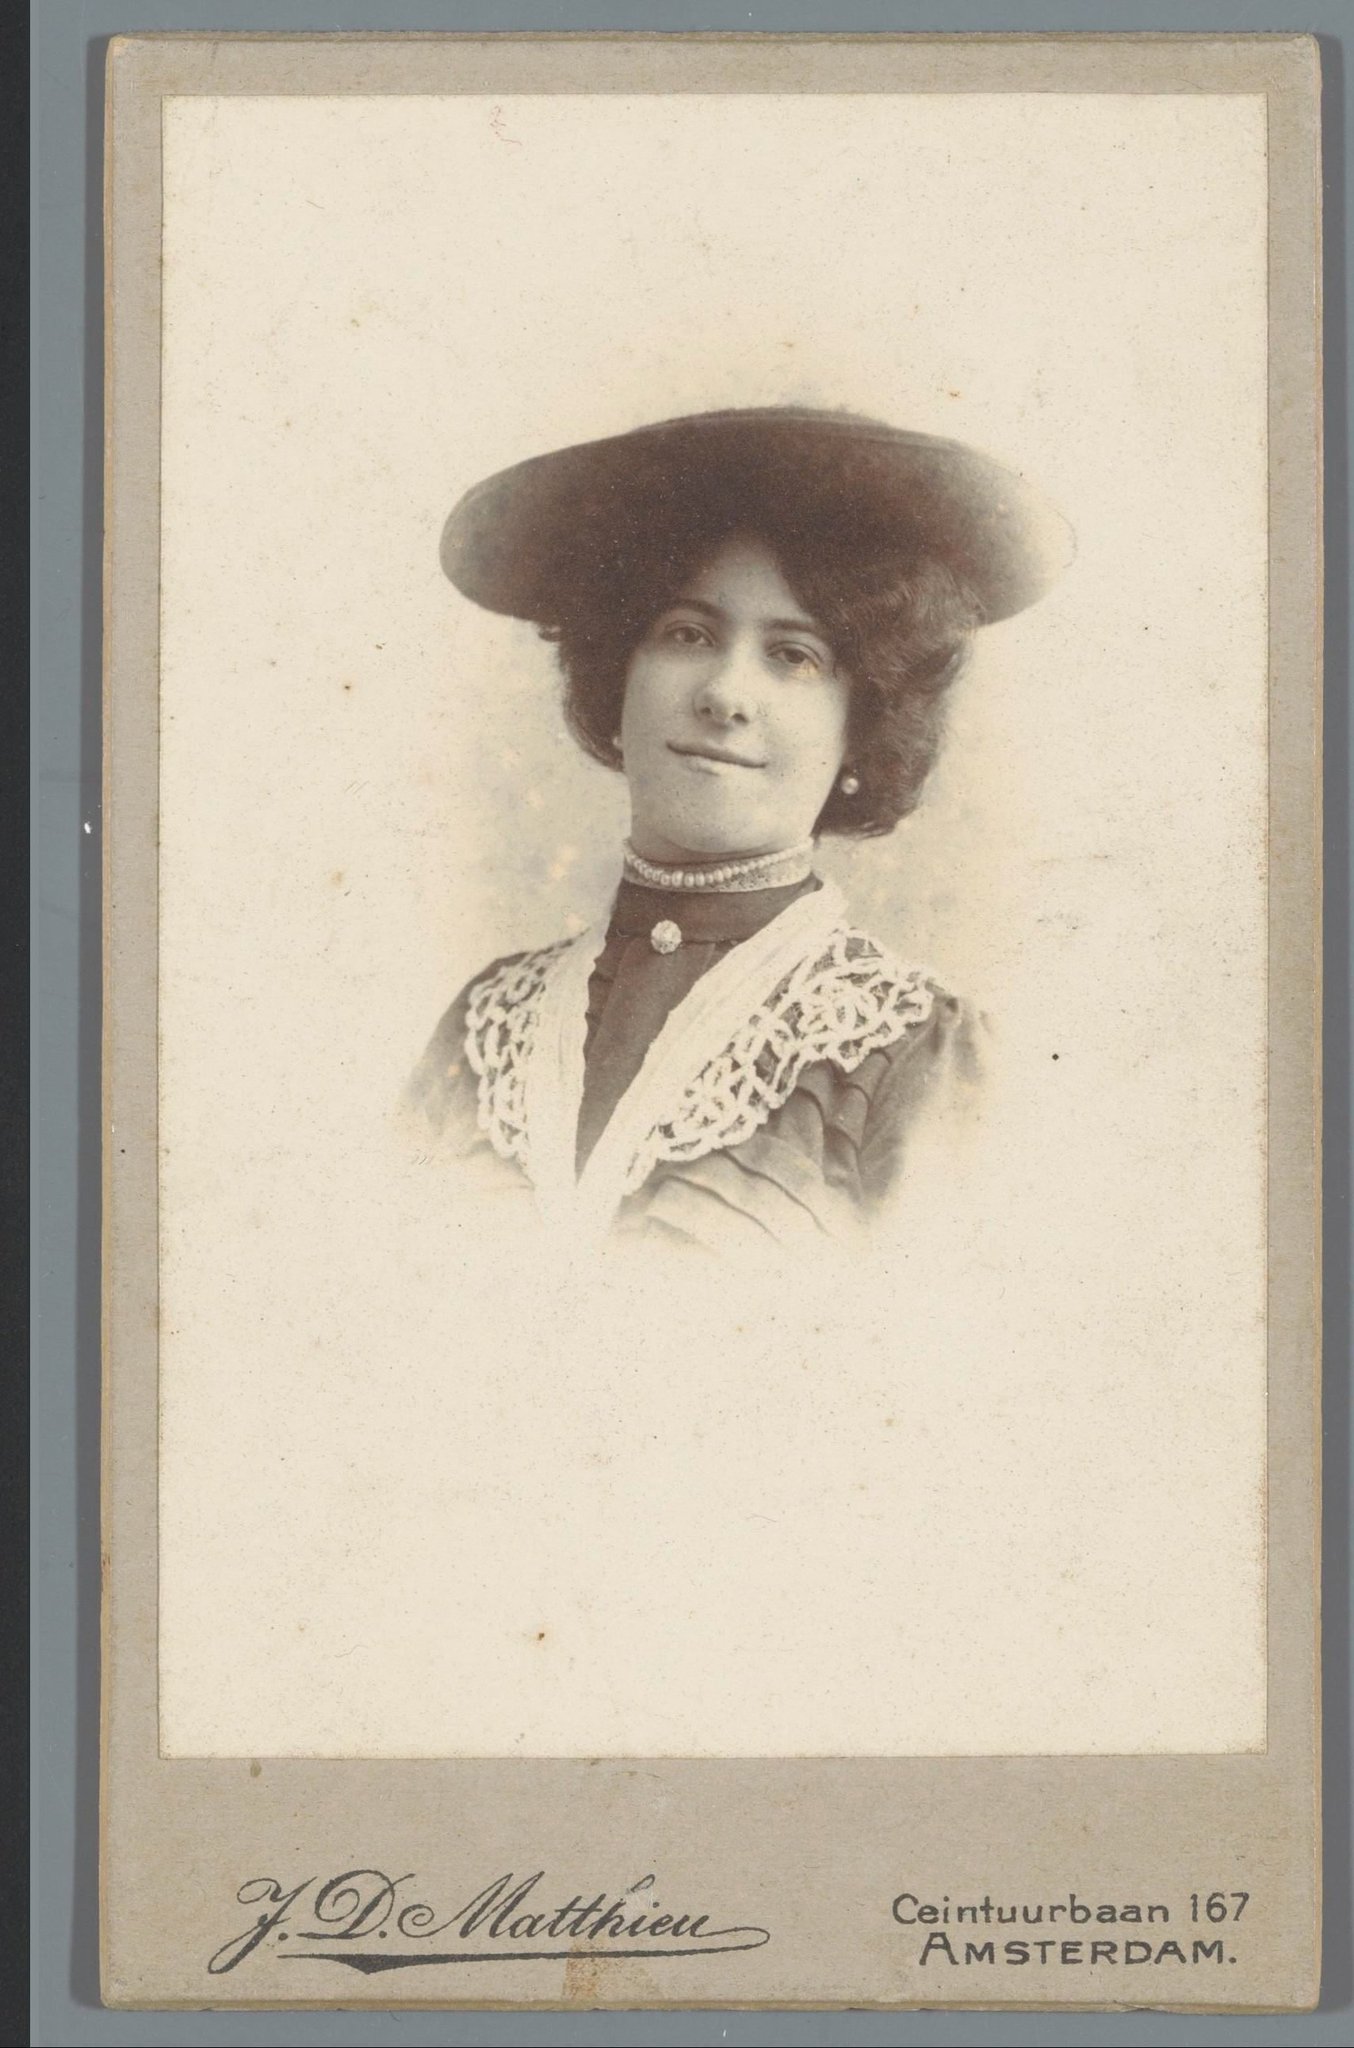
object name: carte de visite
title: Portret van een onbekende vrouw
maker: jean daniel matthieu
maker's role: fotograaf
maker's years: 1865-1926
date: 1890-1907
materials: cardboard, photographic support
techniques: matte daylight collodion silver print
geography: amsterdam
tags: historical persons - bb - woman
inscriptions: inscription: ‘J. D. Matthieu/ Fotografie Artistique/ AMSTERDAM/ Ceintuurbaan 167/ Atelier parterre./ Specialiteit in Vergrootingen.’